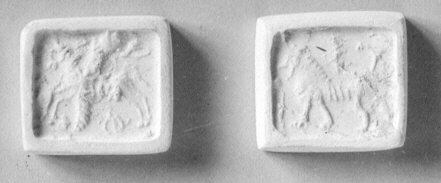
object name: stamp seal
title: Stamp seal (cubical) with animals, monsters, and divine symbols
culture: assyrian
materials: stone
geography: northern syria or anatolia (?)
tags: animals